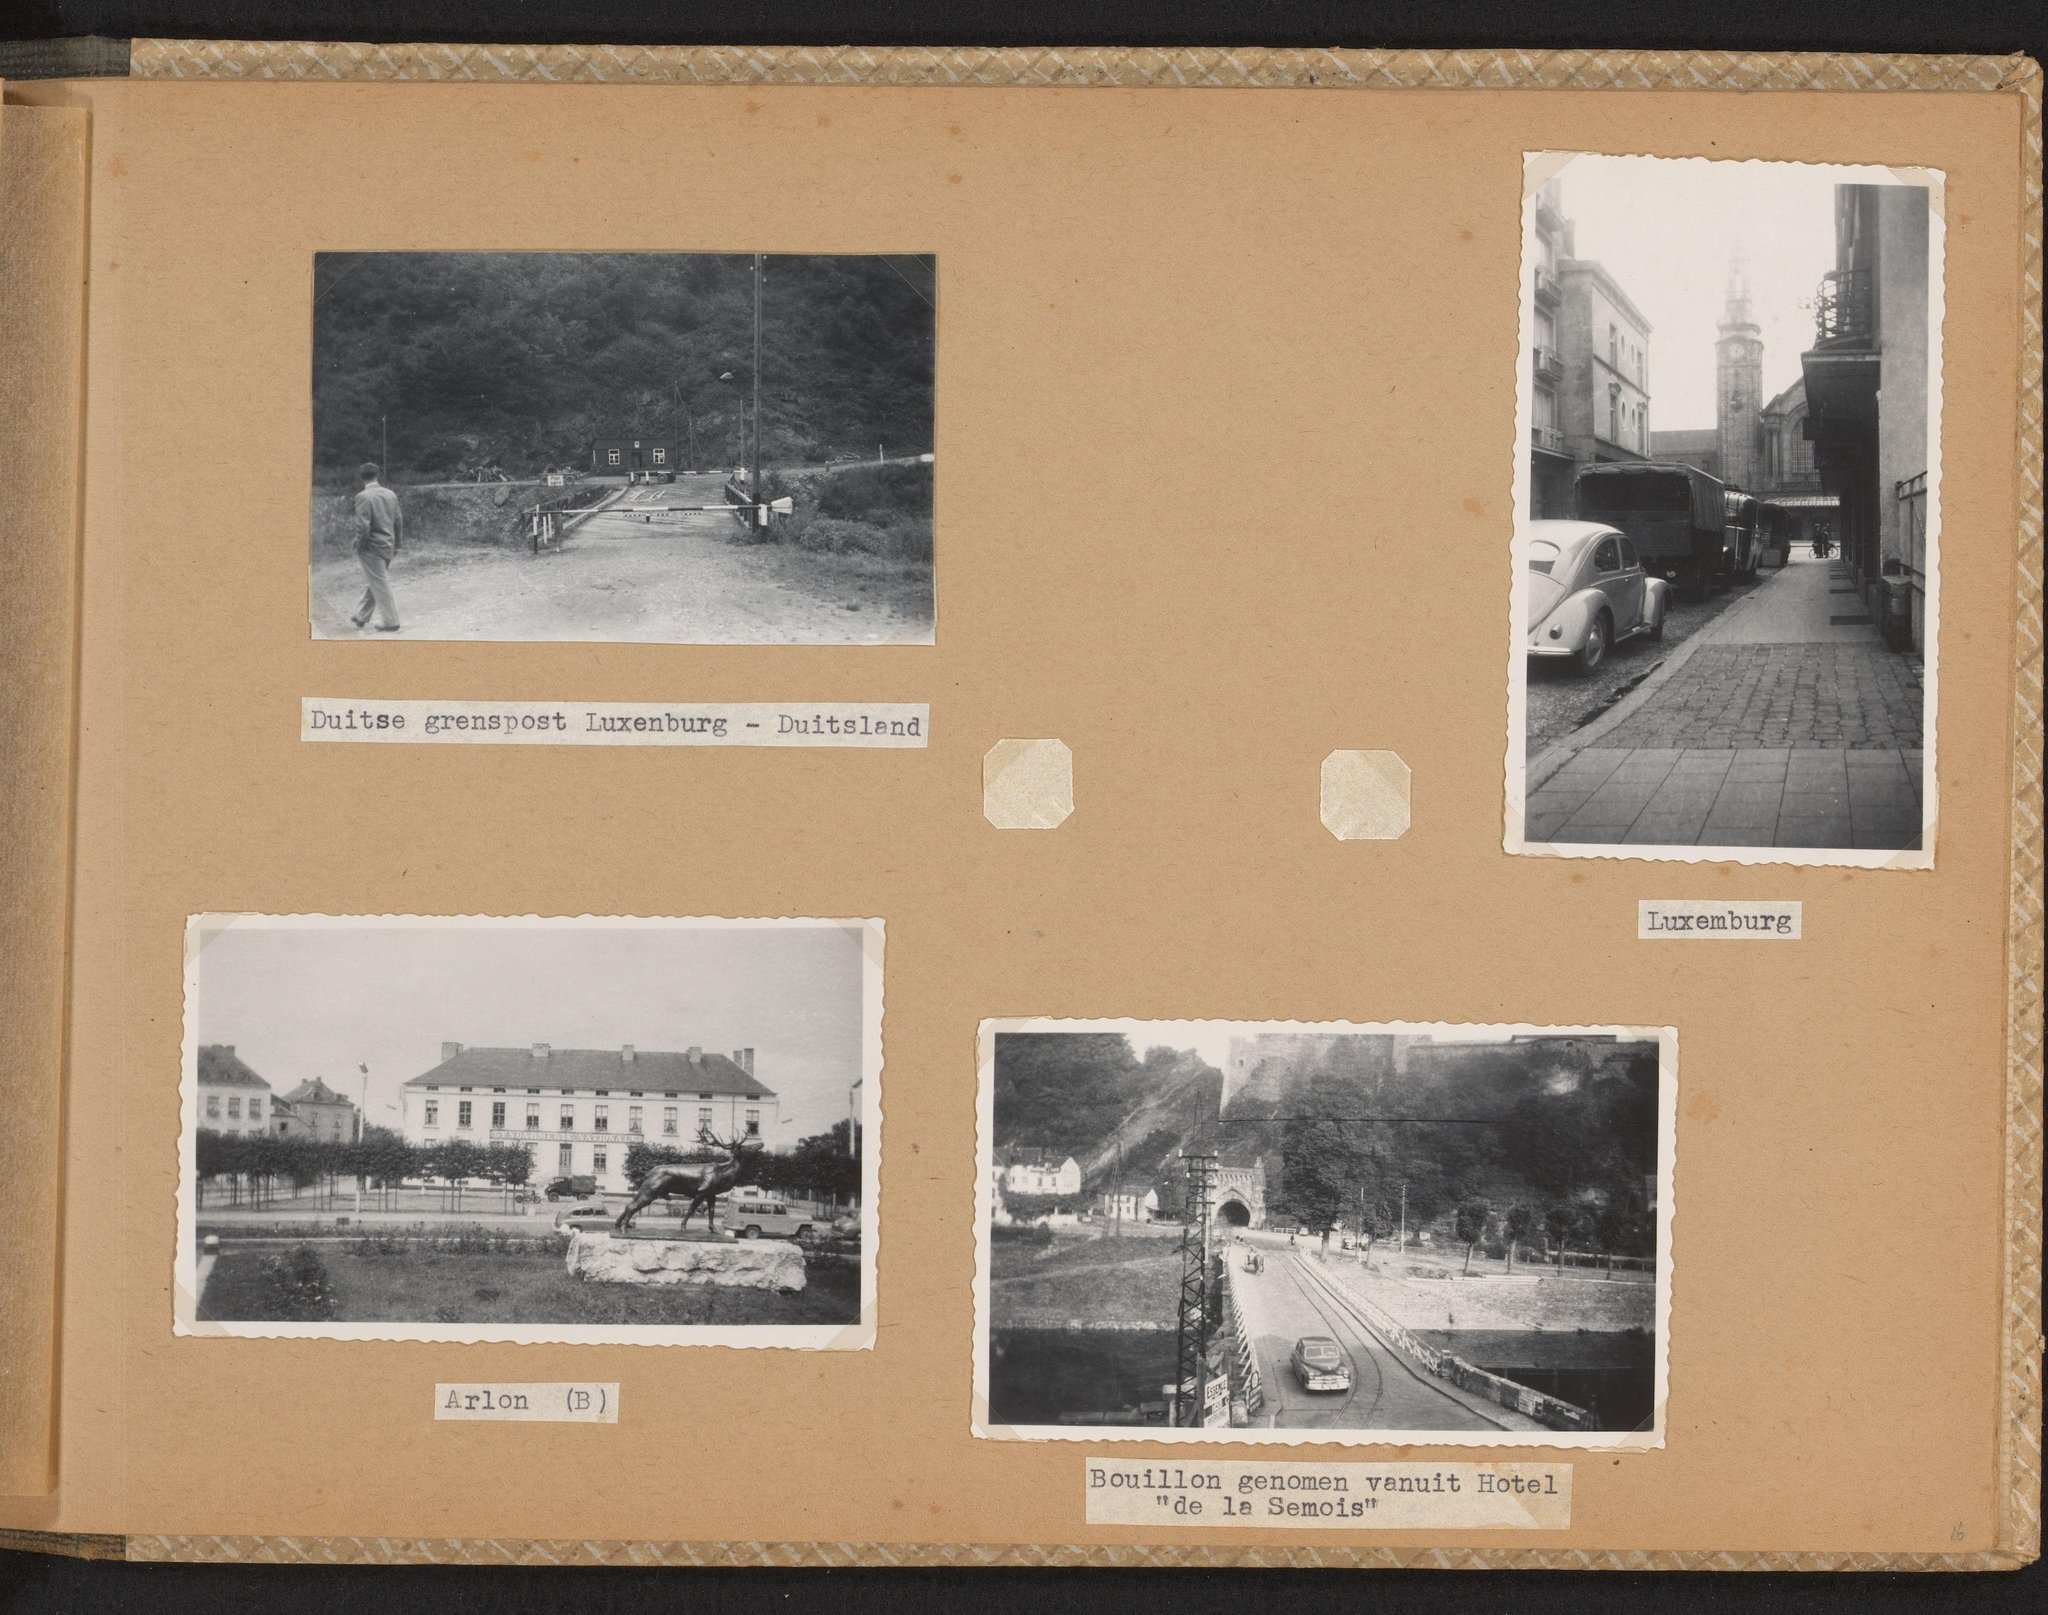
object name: album leaf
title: Omgeving Luxemburg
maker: Anonymous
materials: paper, photographic support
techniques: gelatin silver print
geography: clervaux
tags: the family travelling, on holiday, outing, pleasure trip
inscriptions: inscription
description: Albumblad met vier foto's in de omgeving van Luxemburg, Bouillon en Arlon. Onder de foto's uitgeknipte papiertjes met getypte opschriften. Onderdeel van het tweede fotoalbum met foto's van familievakanties in Nederland, België, Luxemburg en Frankrijk in 1950-1951.